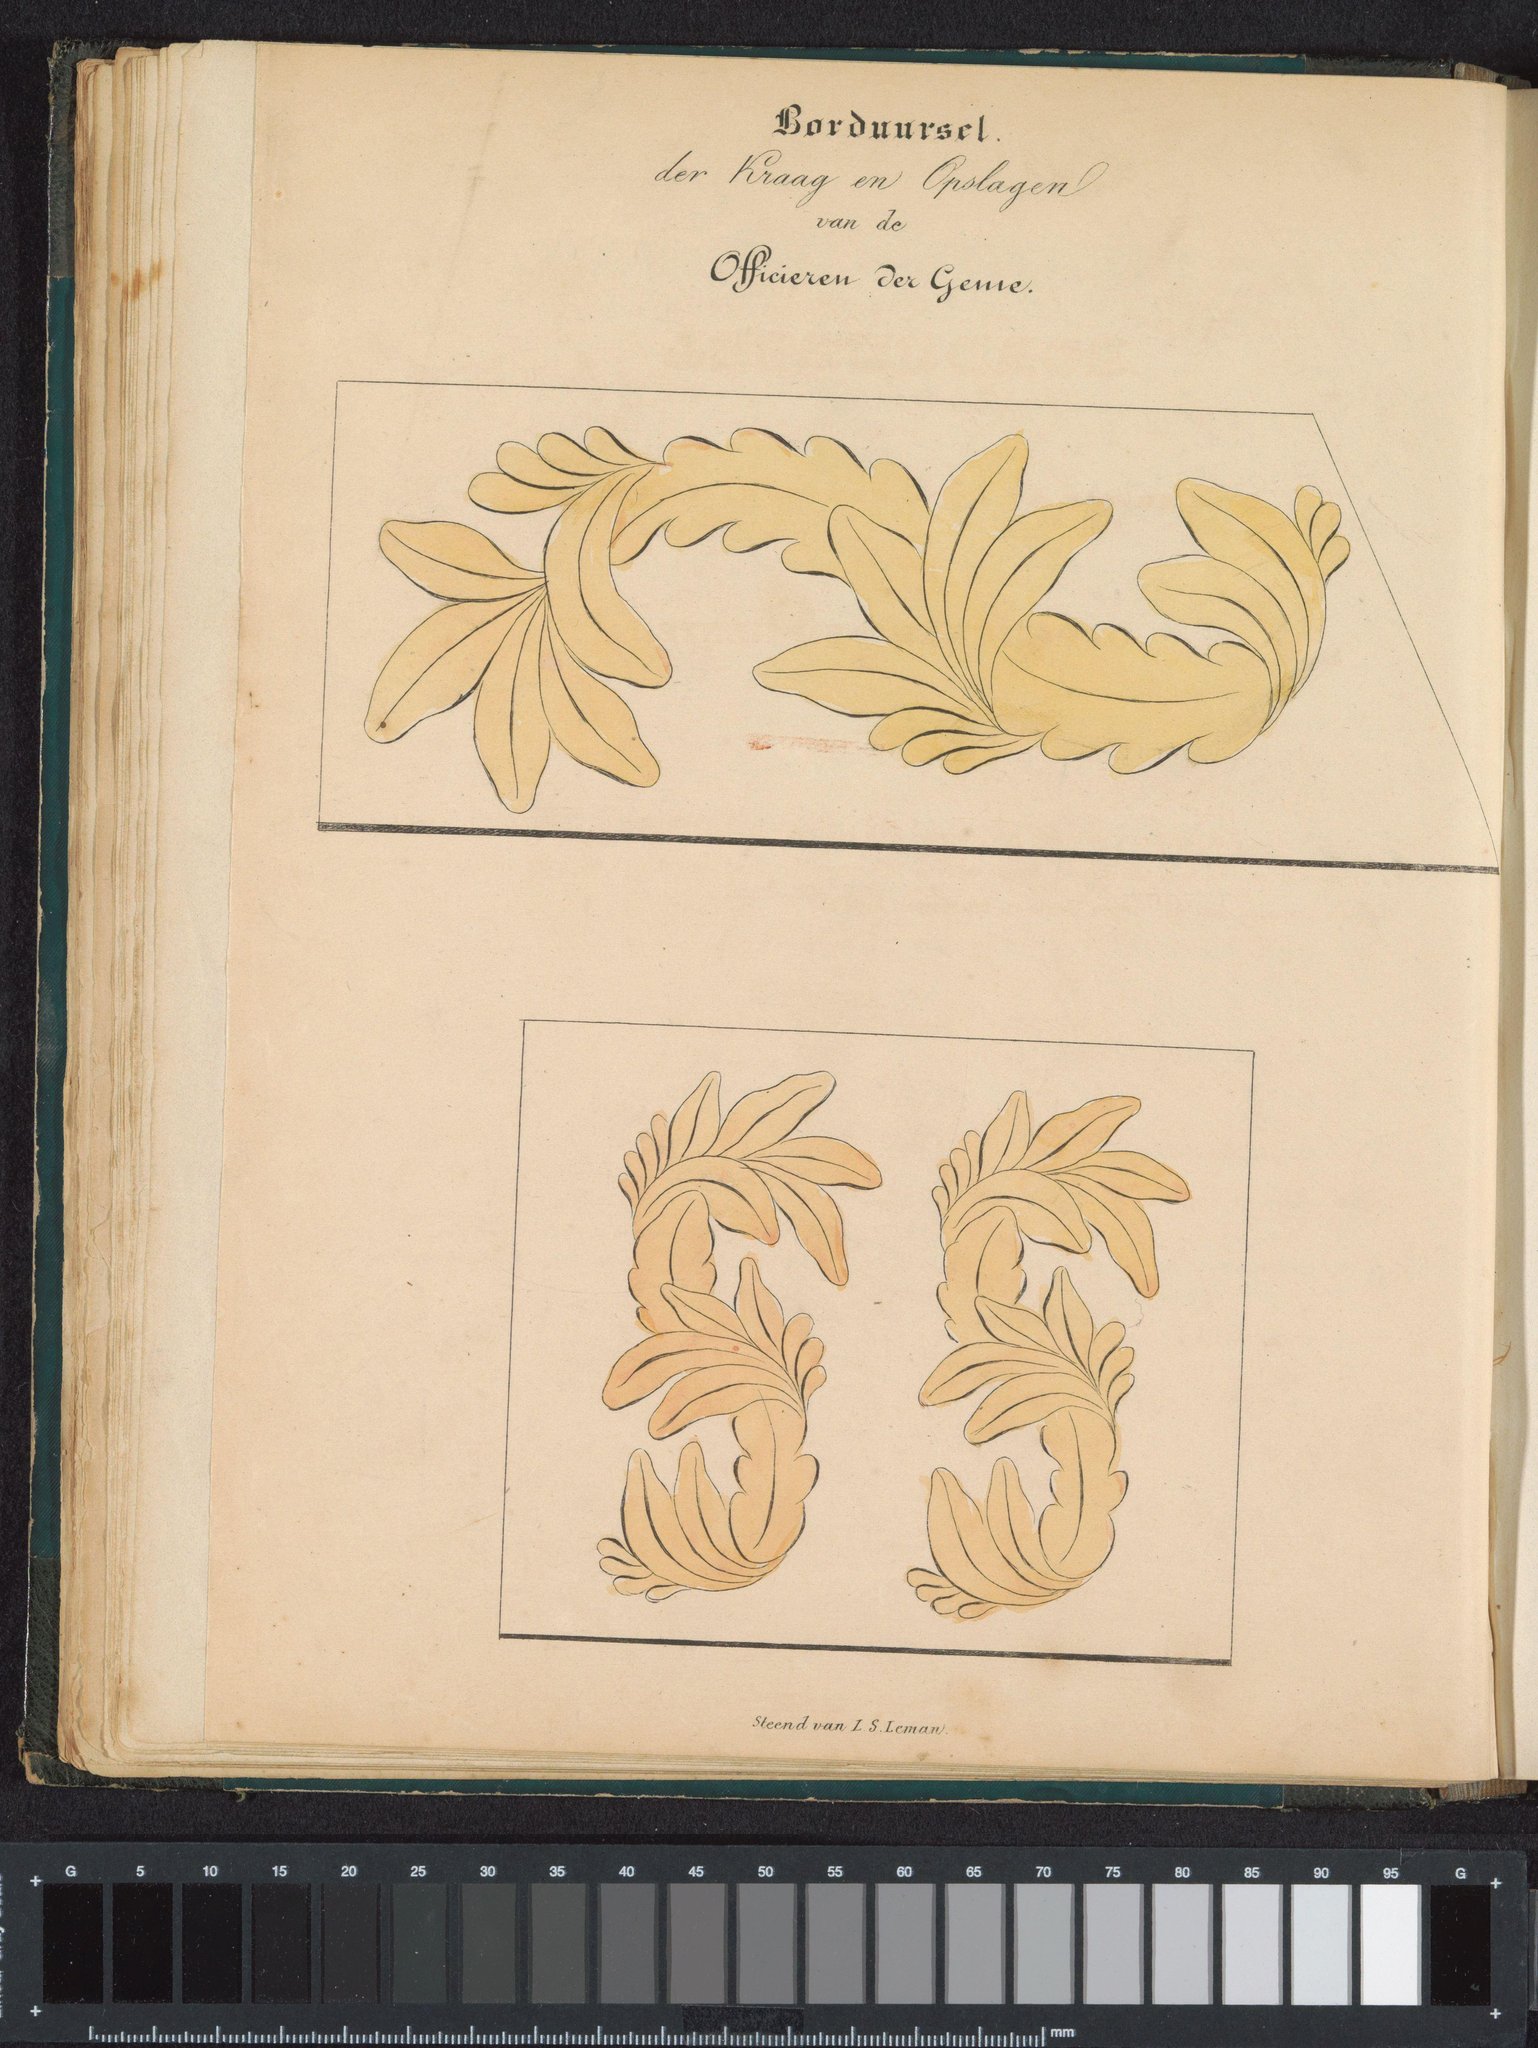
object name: costume print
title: Borduursel der Kraag en Opslagen van de Officieren der Genie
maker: louis salomon leman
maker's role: steendrukker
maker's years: 1818-1889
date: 1845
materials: paper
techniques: hand coloring, lithograph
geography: amsterdam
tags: (military) uniforms, netherlands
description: Borduursel op het uniform van de officieren van de genie. Illustratie in een boek uit 1845 over de uniformen en kledingstukken van de Nederlandse land-, zeemacht en schutterijen in Nederland en in de overzeese gebiedsdelen.